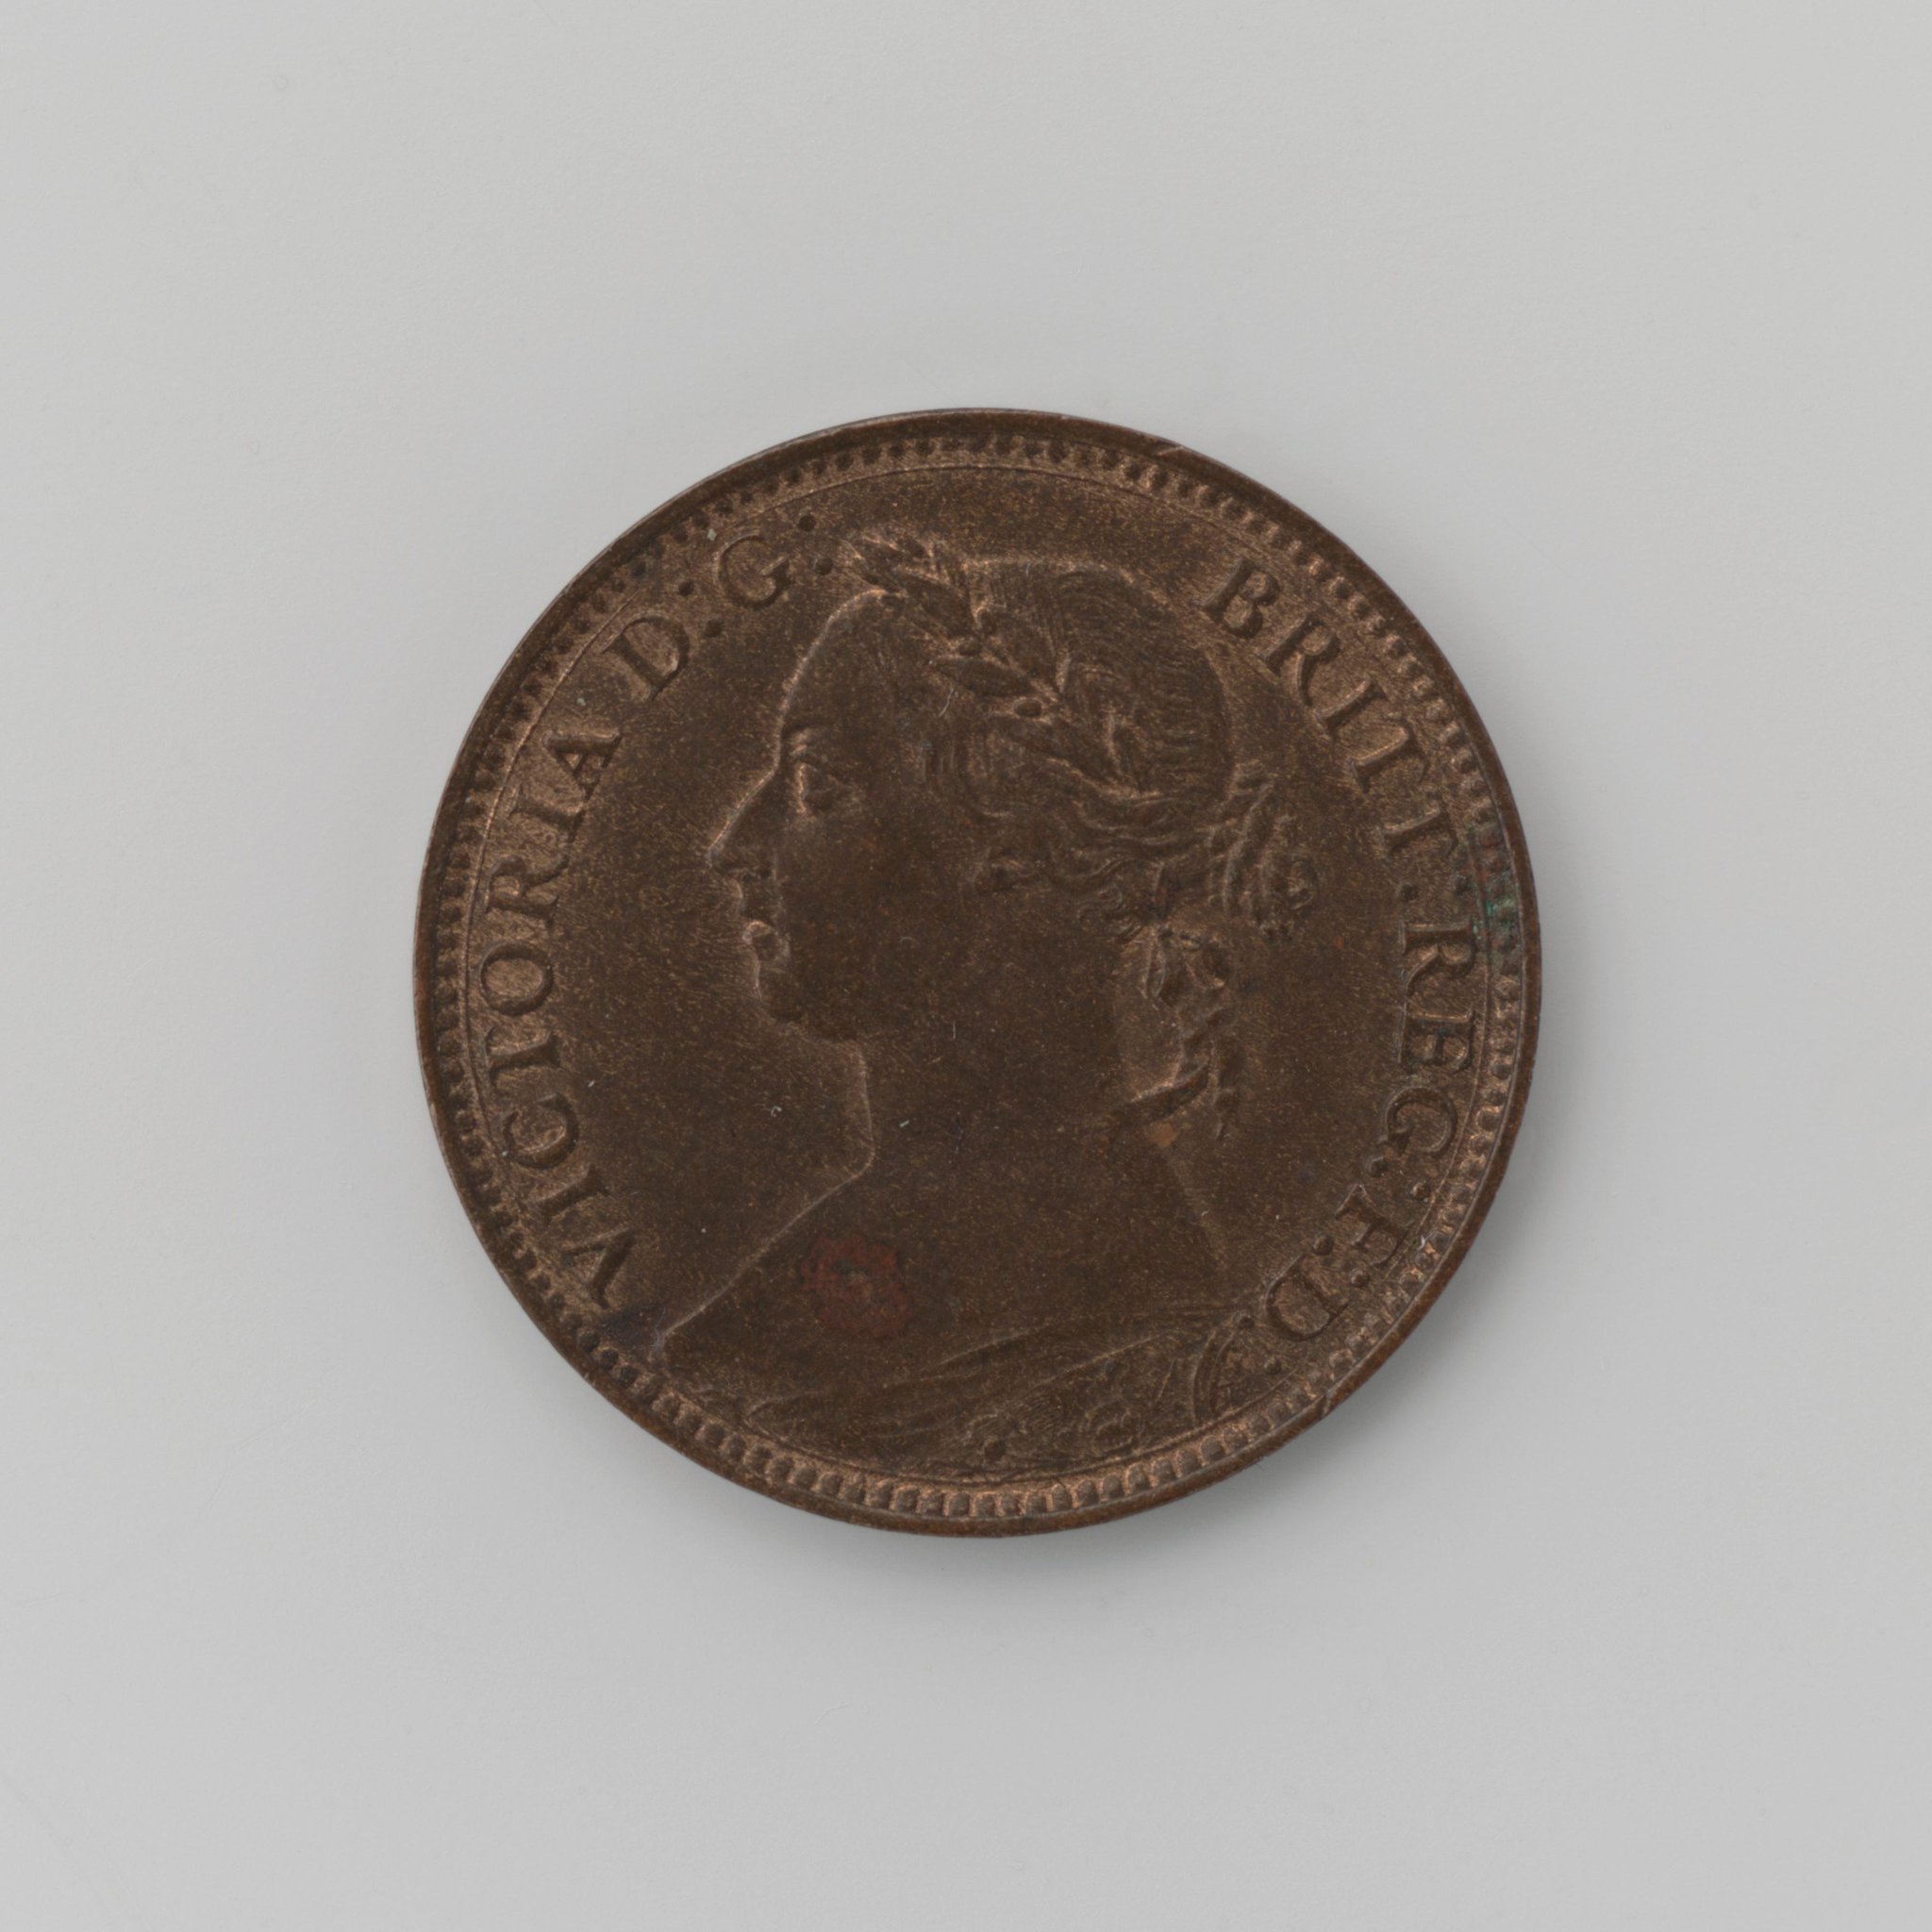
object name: coin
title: Engeland, Victoria, farthing, 1893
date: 1893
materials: bronze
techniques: striking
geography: london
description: Bronzen munt. Voorzijde: hoofd van de koningin met lauwerkrans naar links [bun head]. Keerzijde: tegen wapenschild gezeten Brittannia met drietand, naar rechts. Links van haar vuurtoren, rechts schip. In afsnede jaartal. Waarde-aanduiding als omschrift. Gladde rand.